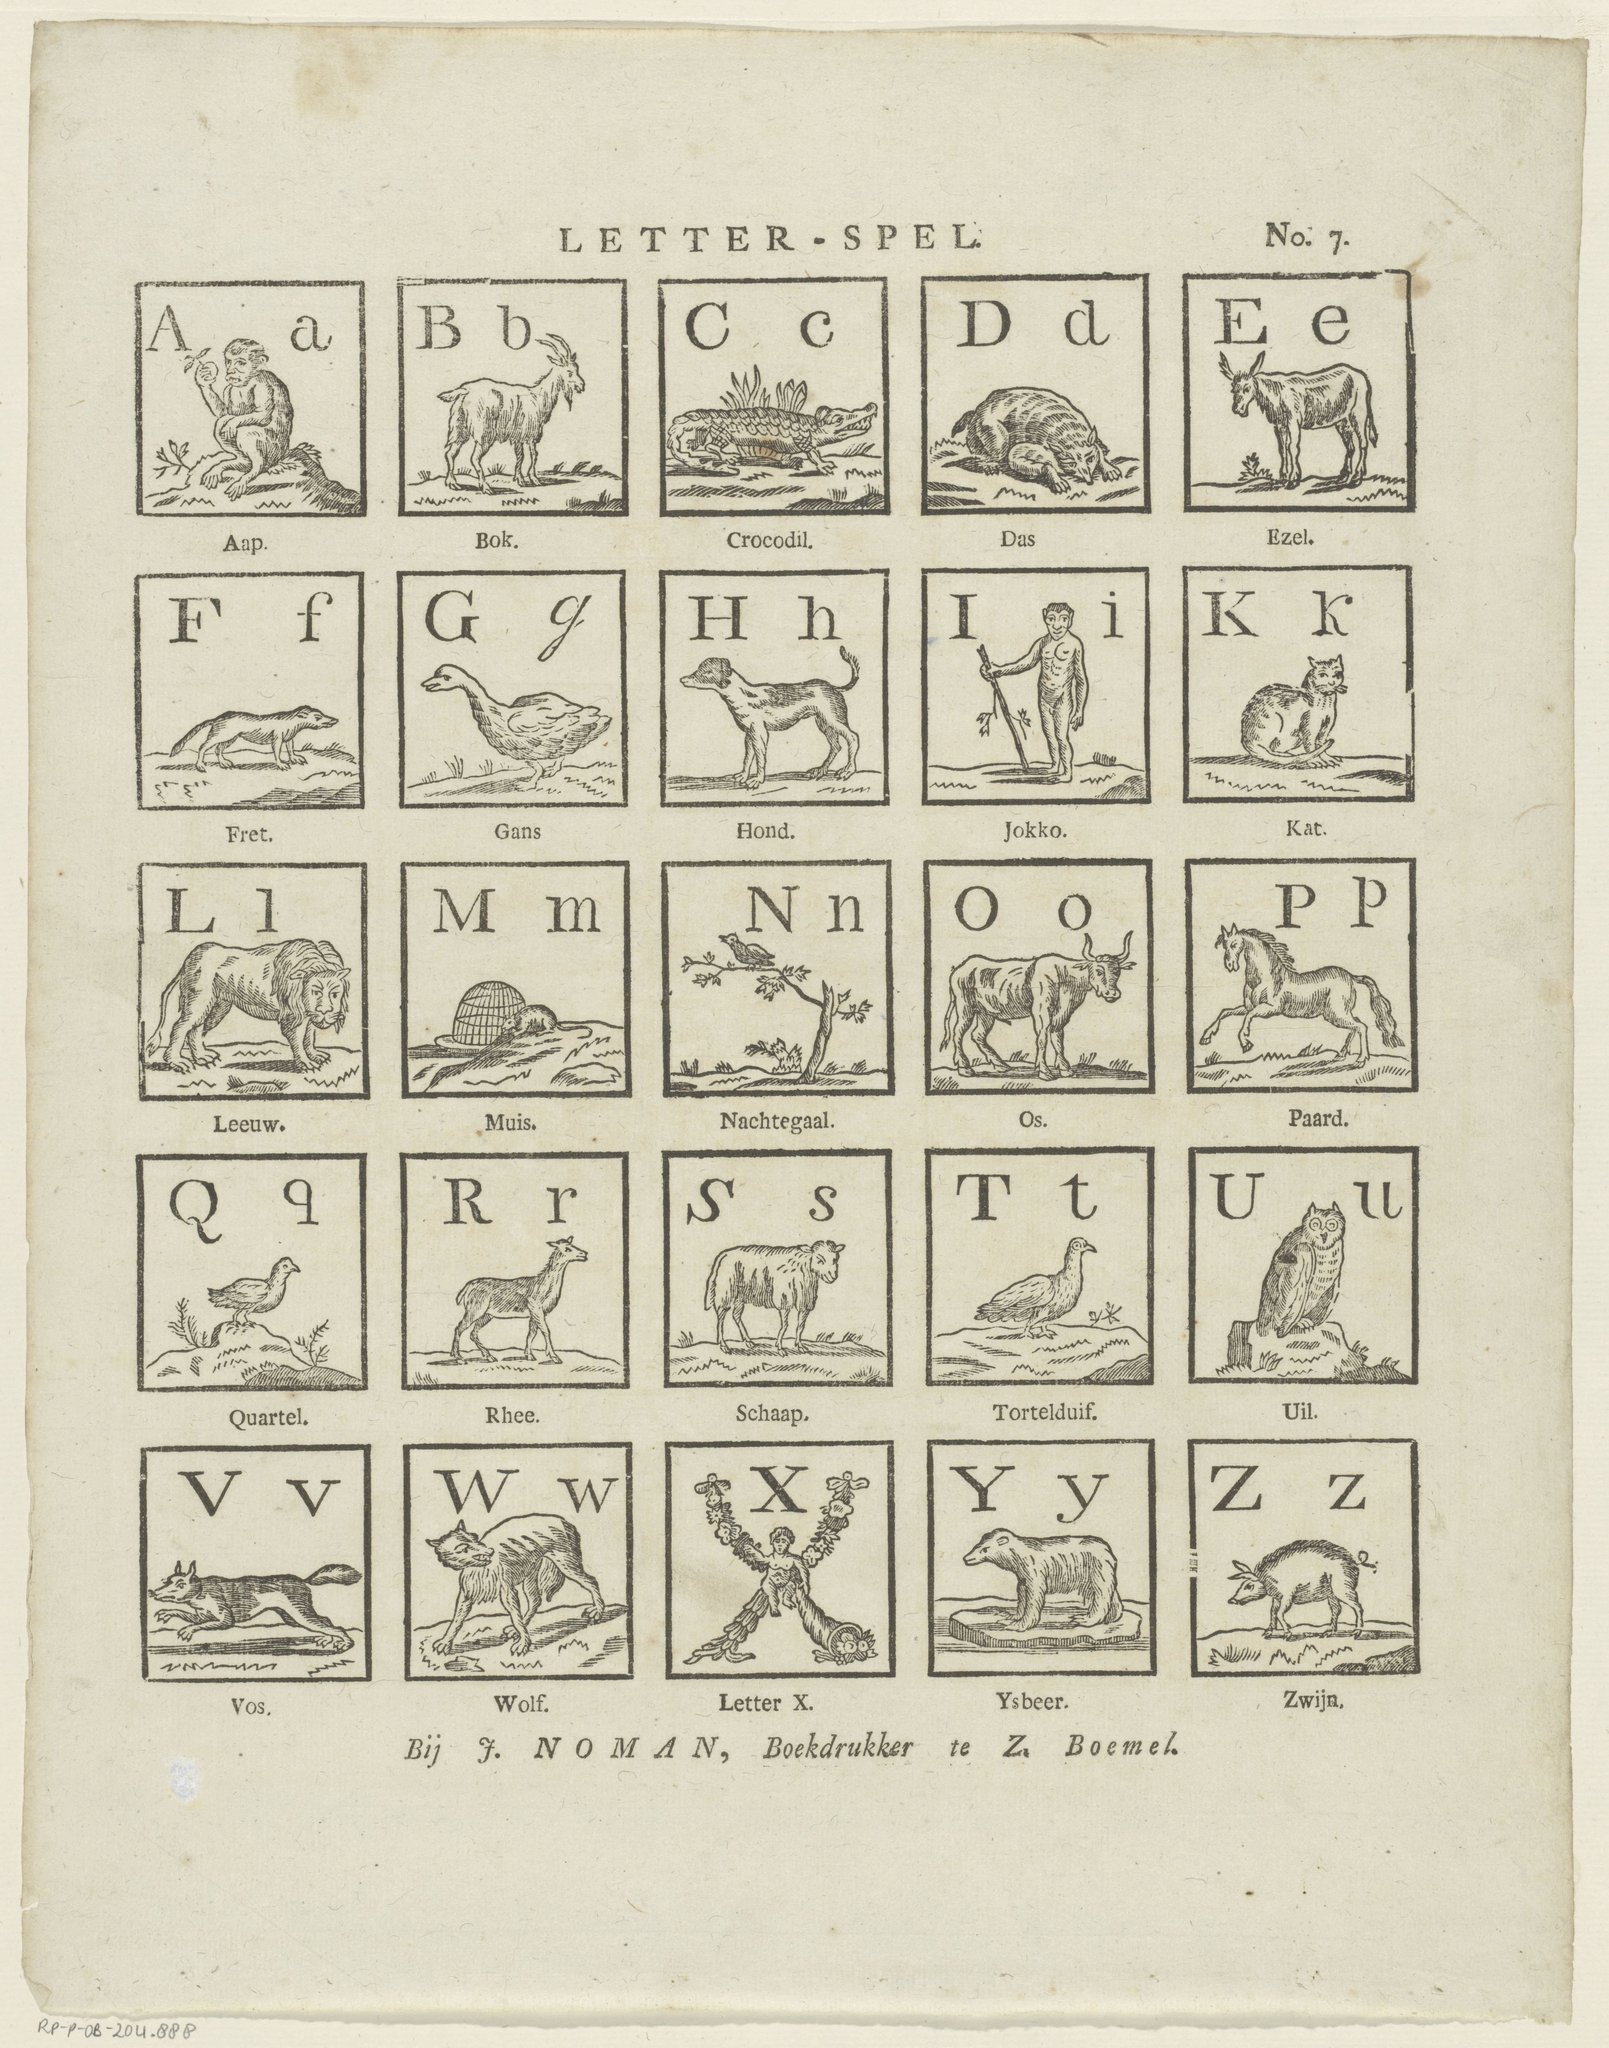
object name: print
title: Letter-spel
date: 1806-1830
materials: paper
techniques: letterpress printing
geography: netherlands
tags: animals, letters, alphabet, script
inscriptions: collector's mark: Lugt 2760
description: Blad met 25 voorstellingen van de letters van het alfabet geïllustreerd met dieren waarvan de woorden met de betreffende letter beginnen. Onder elke afbeelding de naam van het dier in boekdruk. Genummerd rechtsboven: No. 7.